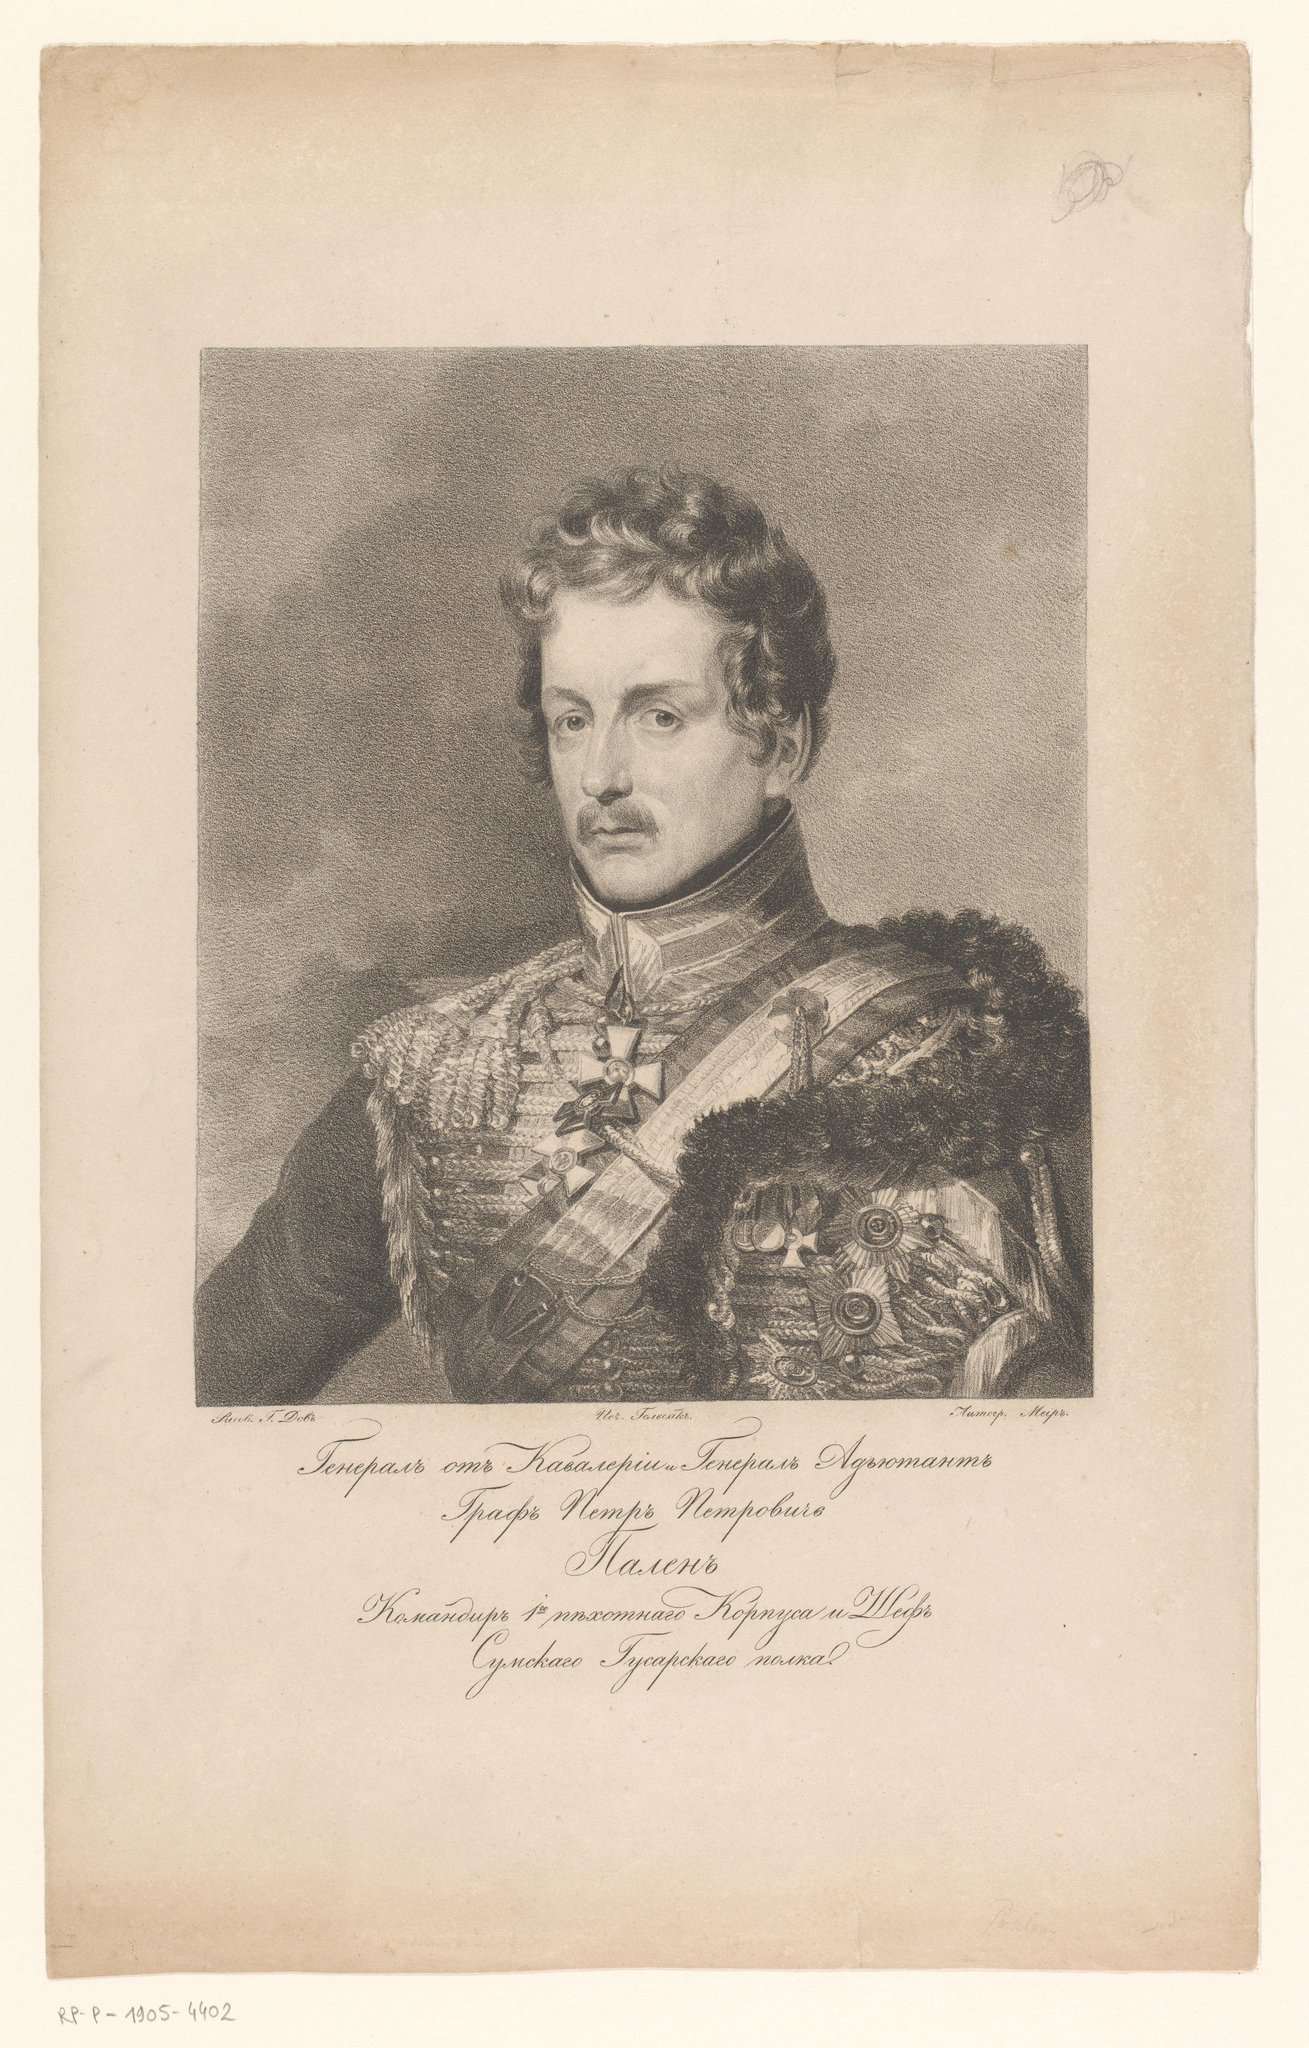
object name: print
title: Portret van een onbekende man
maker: Anonymous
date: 1820-1890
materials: paper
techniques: lithograph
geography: eastern europe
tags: moustache, adult man, historical persons, (military) uniforms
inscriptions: collector's mark: Lugt 2228